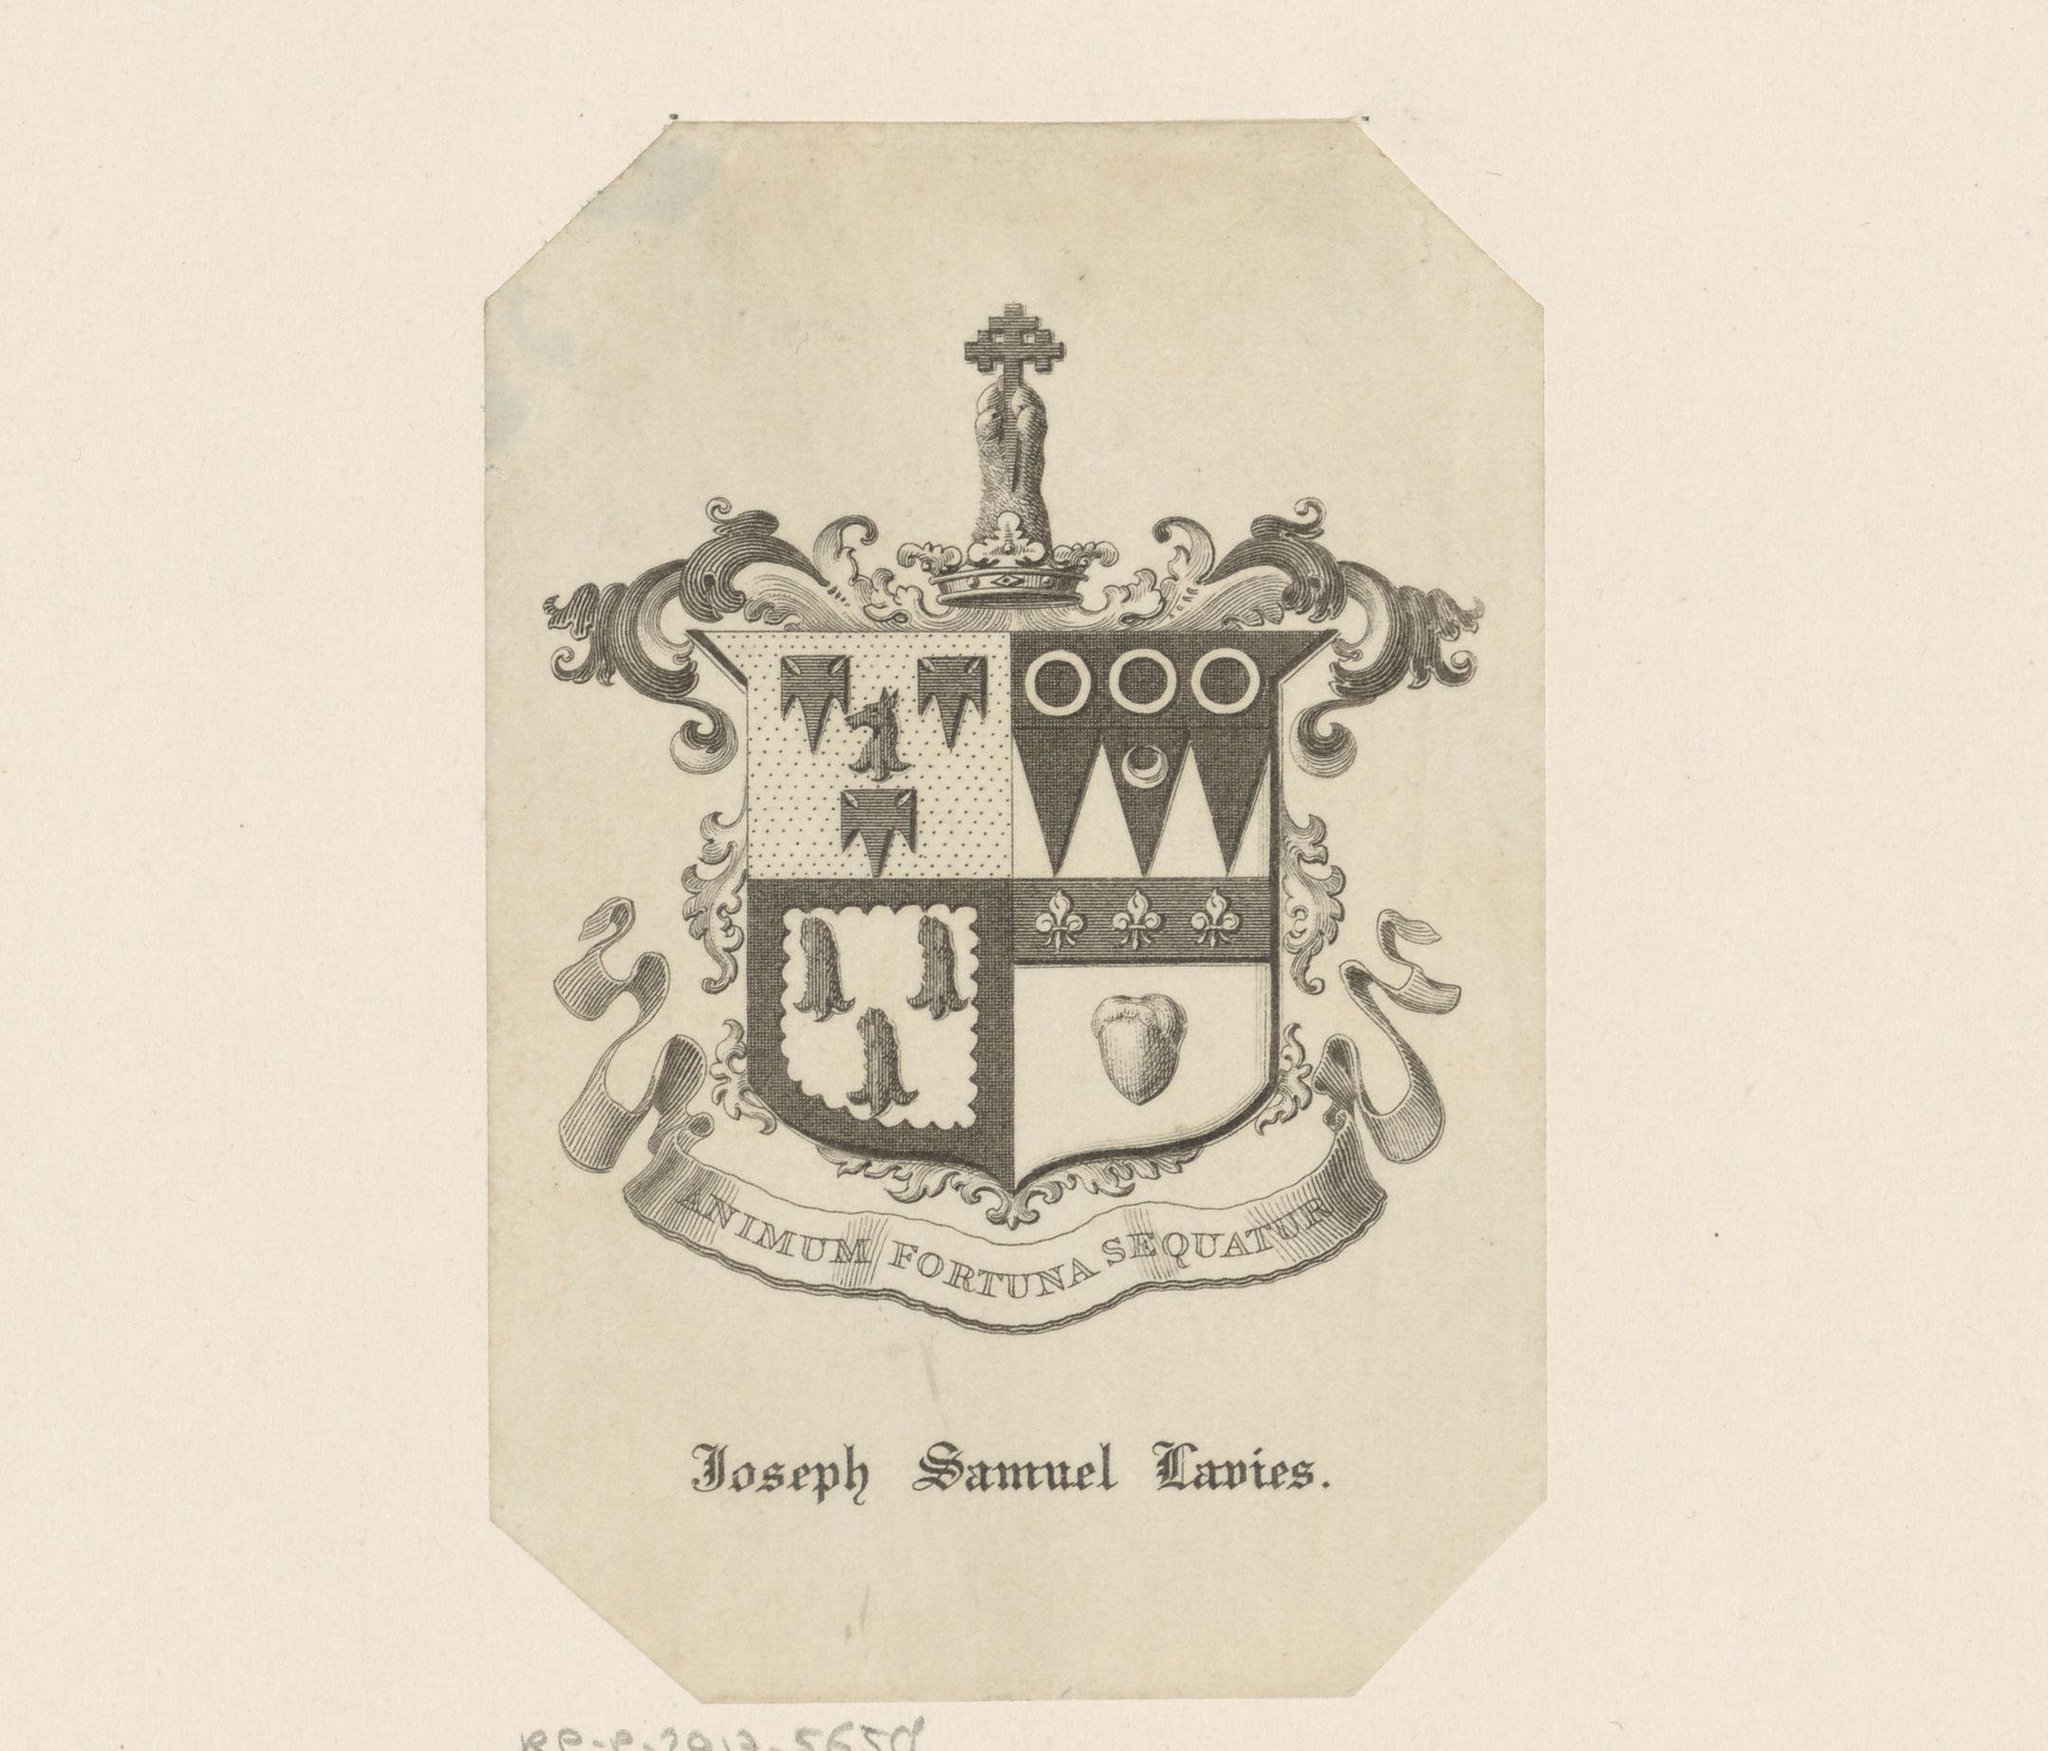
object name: bookplate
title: Ex libris van Joseph Samuel Lavies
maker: Anonymous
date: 1834-1888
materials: paper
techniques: etching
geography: england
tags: armorial bearing, heraldry